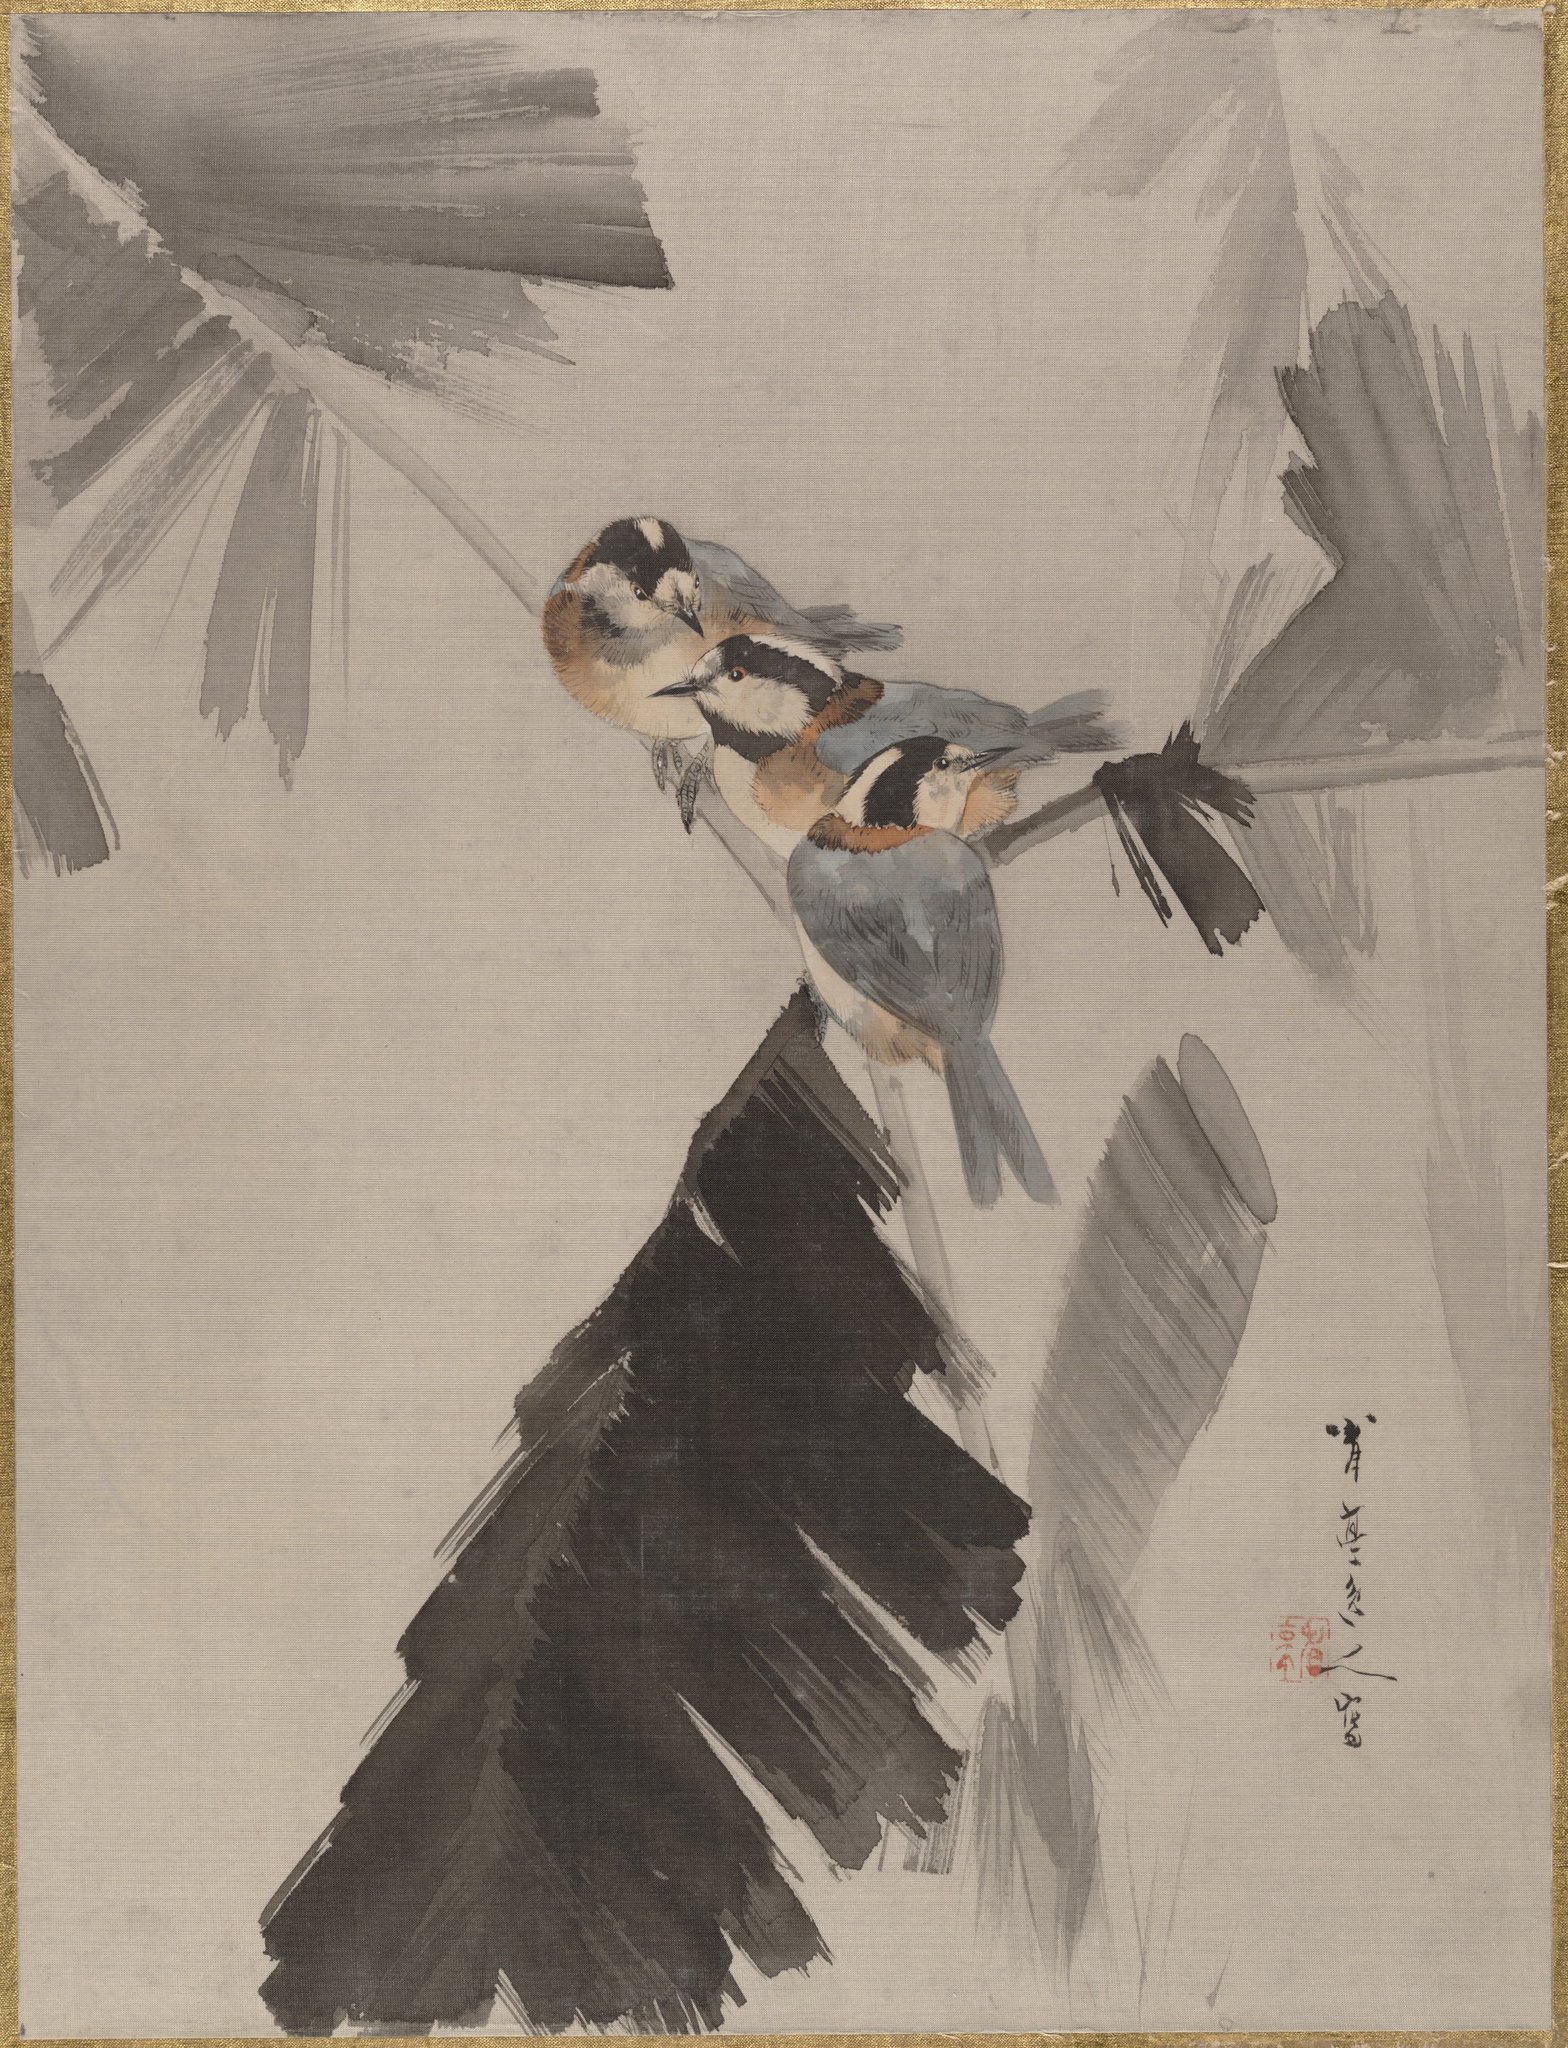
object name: album leaf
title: Three Birds on Branch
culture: japanese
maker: watanabe seitei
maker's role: artist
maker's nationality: japanese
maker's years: 1851-1918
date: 1887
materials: ink, silk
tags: birds